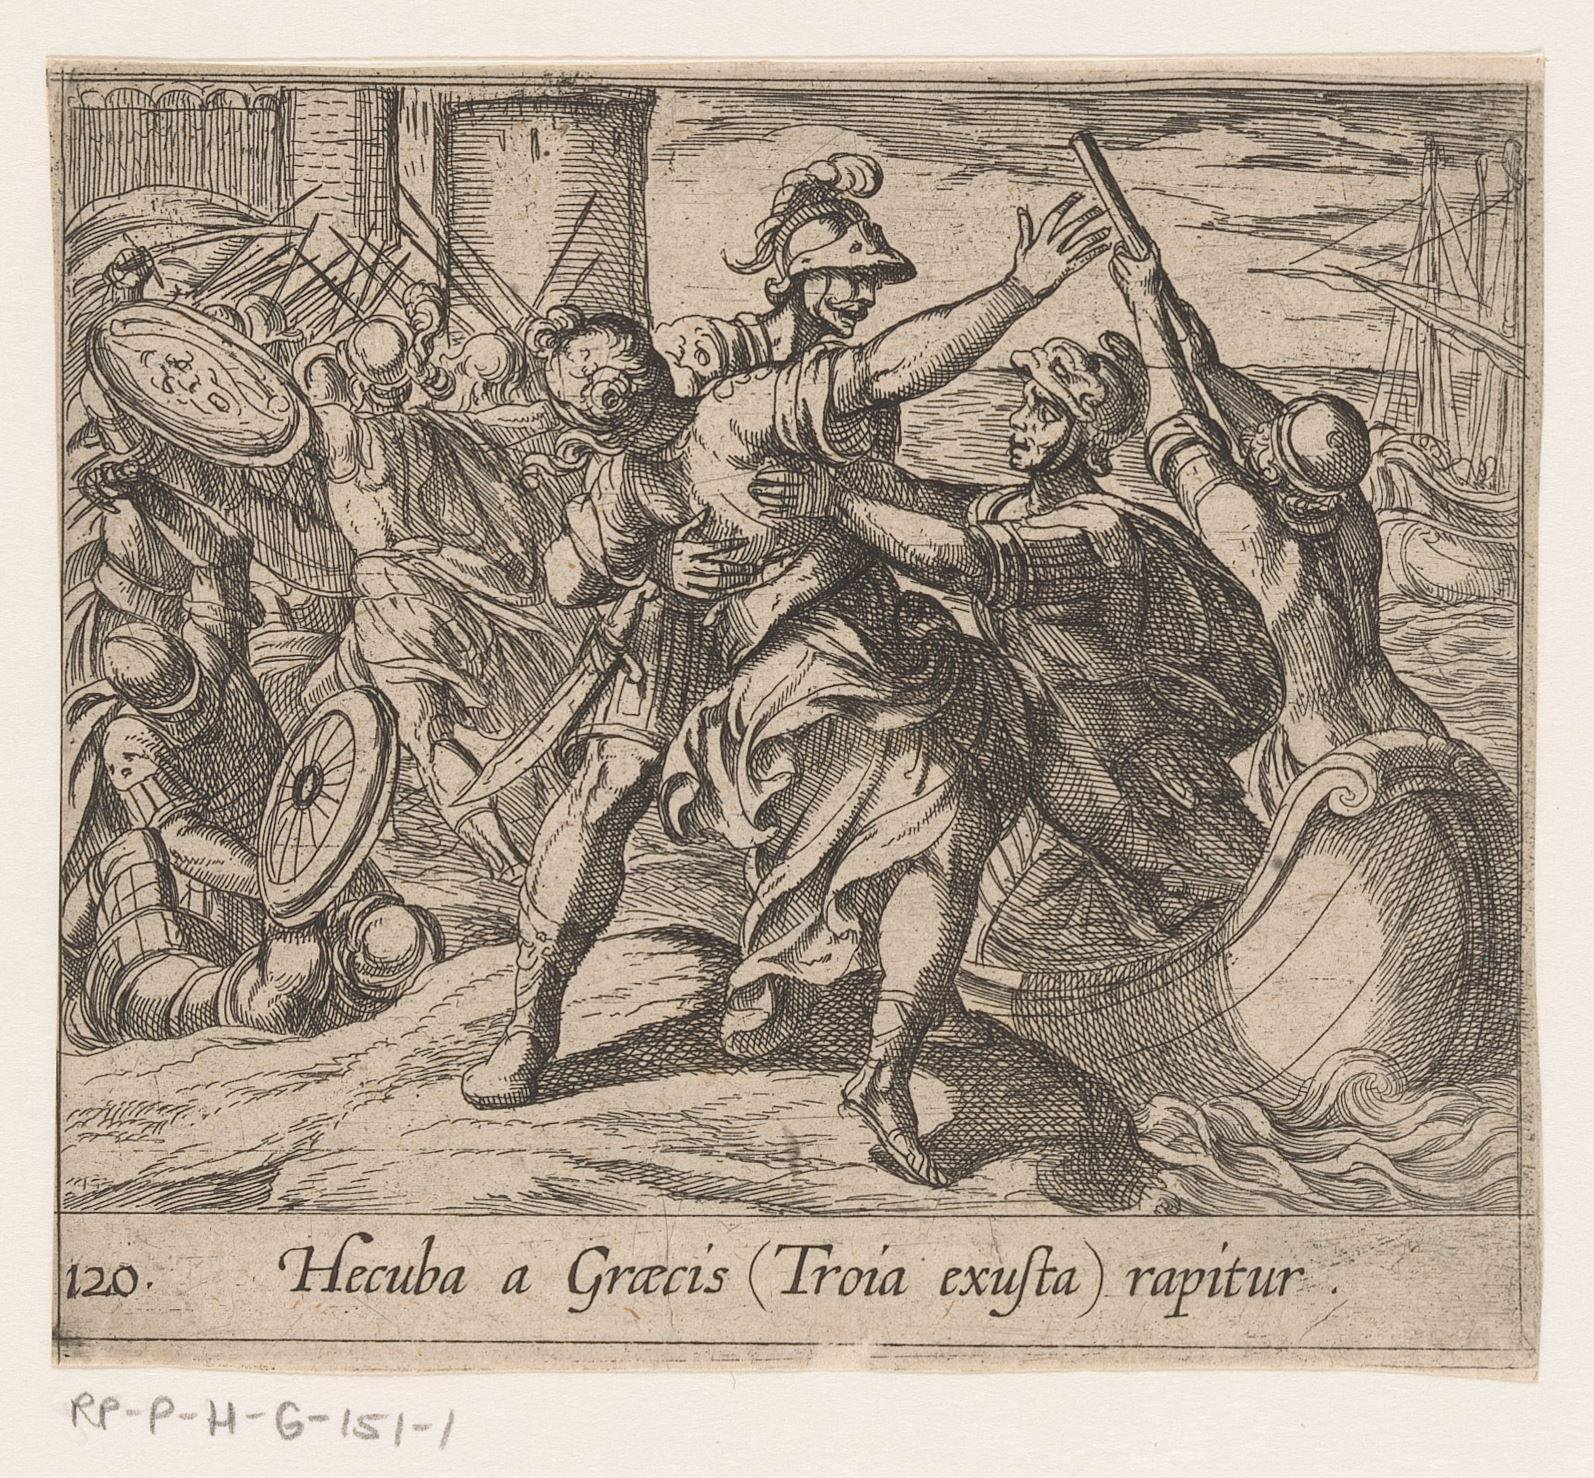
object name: print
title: Metamorphoseon sive transformationum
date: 1606-1638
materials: paper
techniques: etching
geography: amsterdam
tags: (story of) hecuba, slavery; serfs and enslaved persons, kidnapping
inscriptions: collector's mark: ‘Hinloopen’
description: De Trojaanse koningin Hekabe wordt door Griekse soldaten ontvoerd om de slaafgemaakte van opperbevelhebber Agamemnon te worden. Titel in het Latijn in ondermarge.